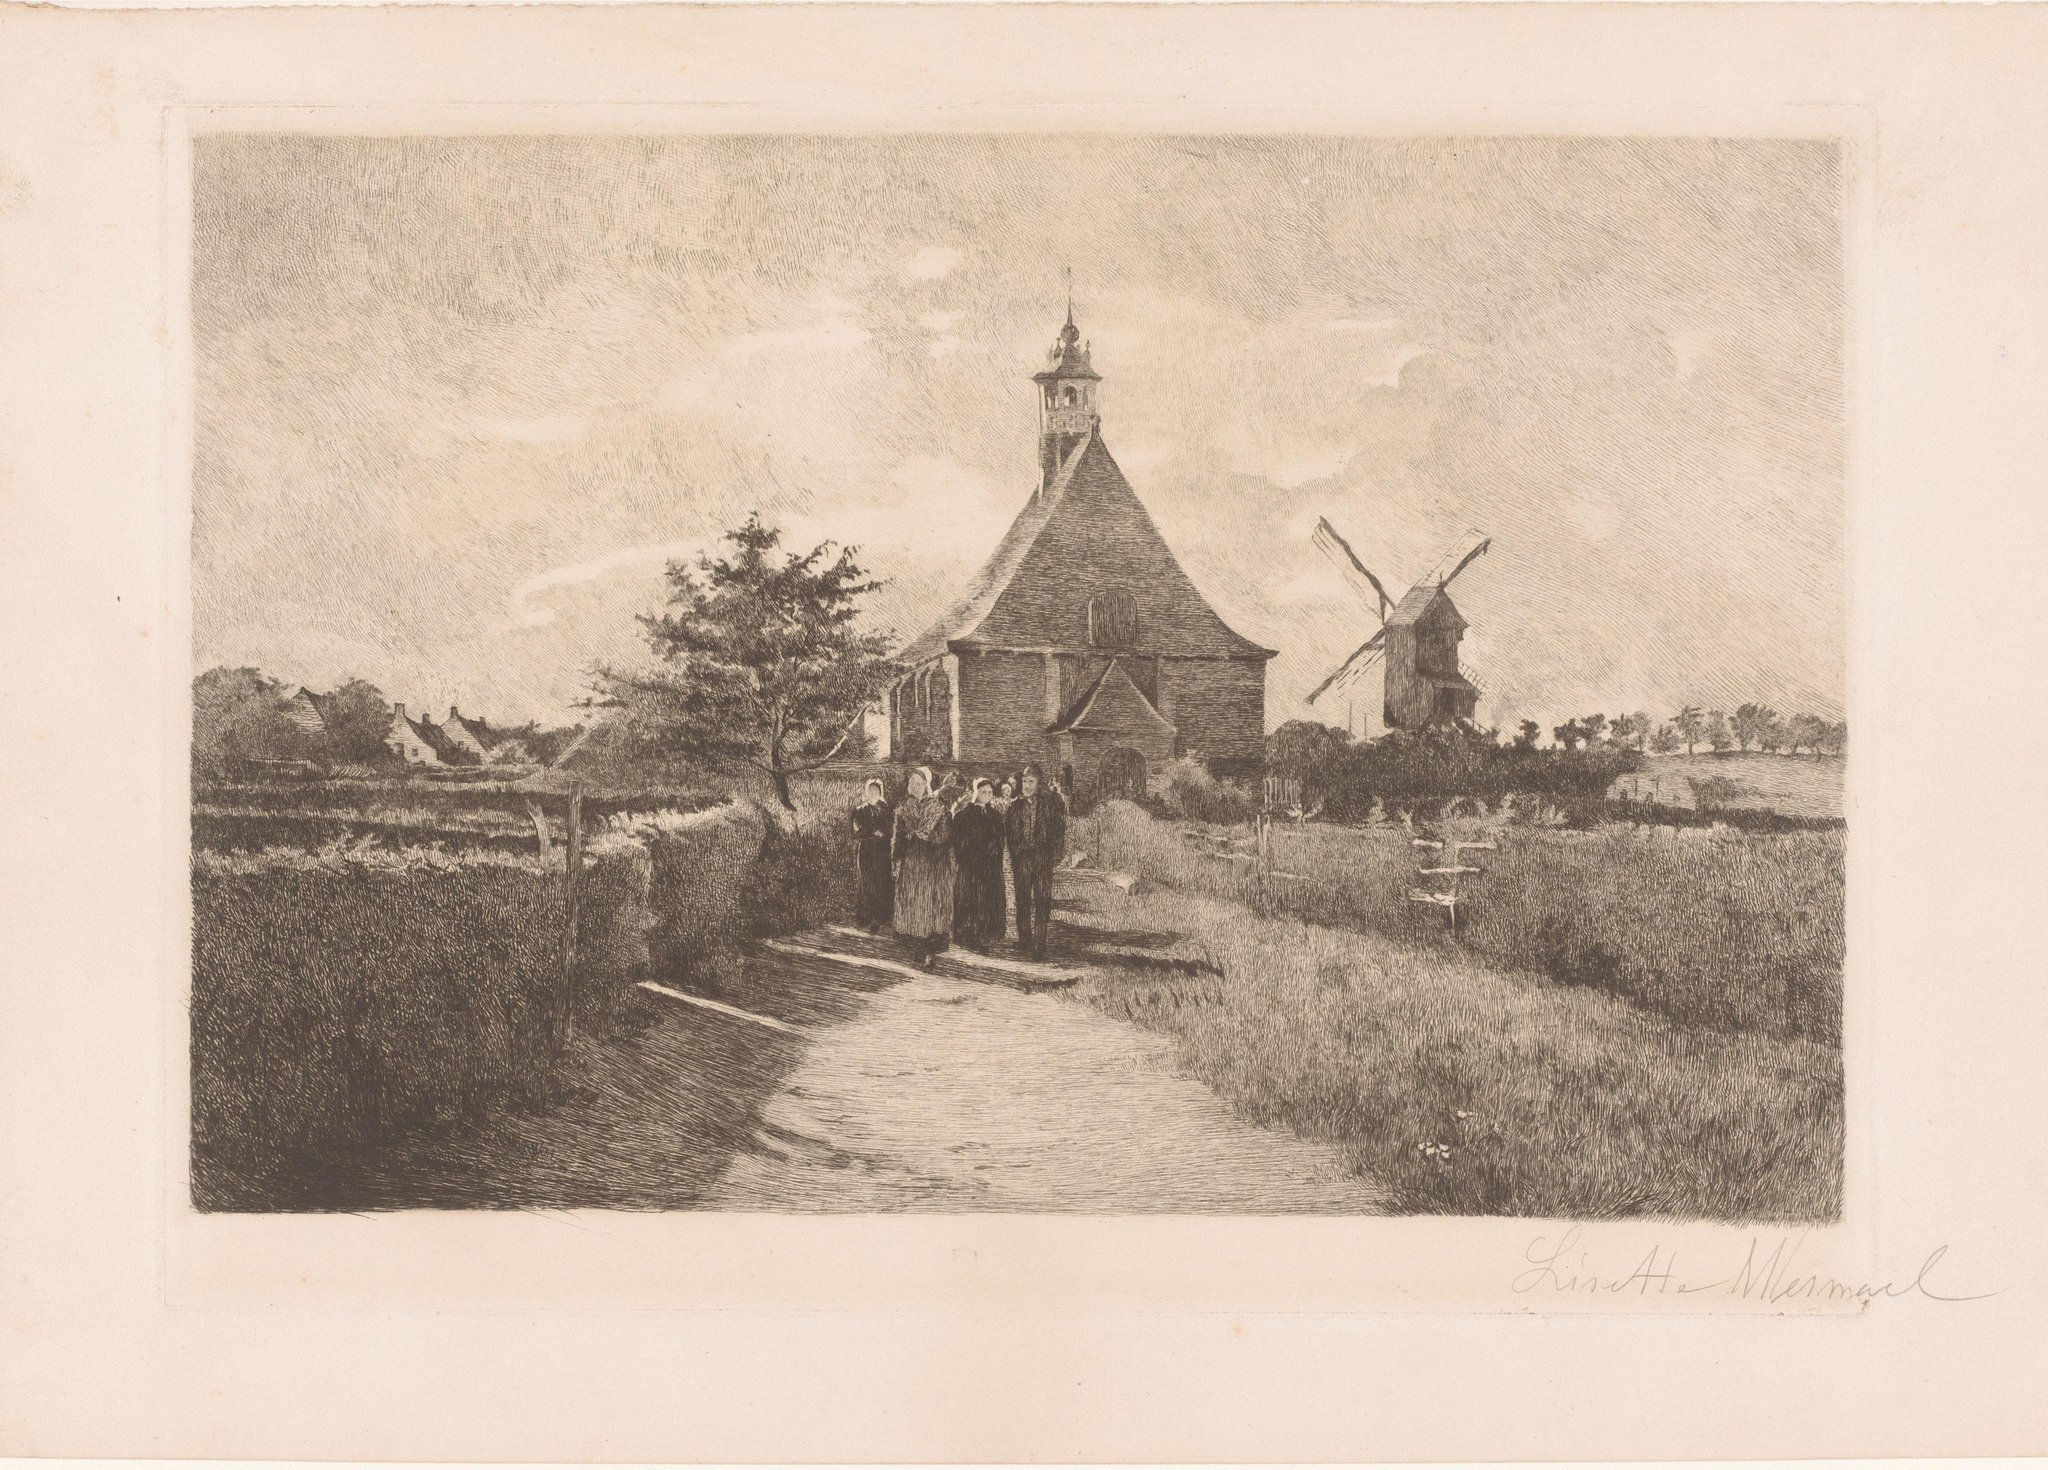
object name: print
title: Uitgaan van de kerk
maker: lisette wesmael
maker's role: print maker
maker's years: 1861-1953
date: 1883-1913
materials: paper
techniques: etching, retroussage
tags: leaving the church after service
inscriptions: collector's mark: Lugt 2228